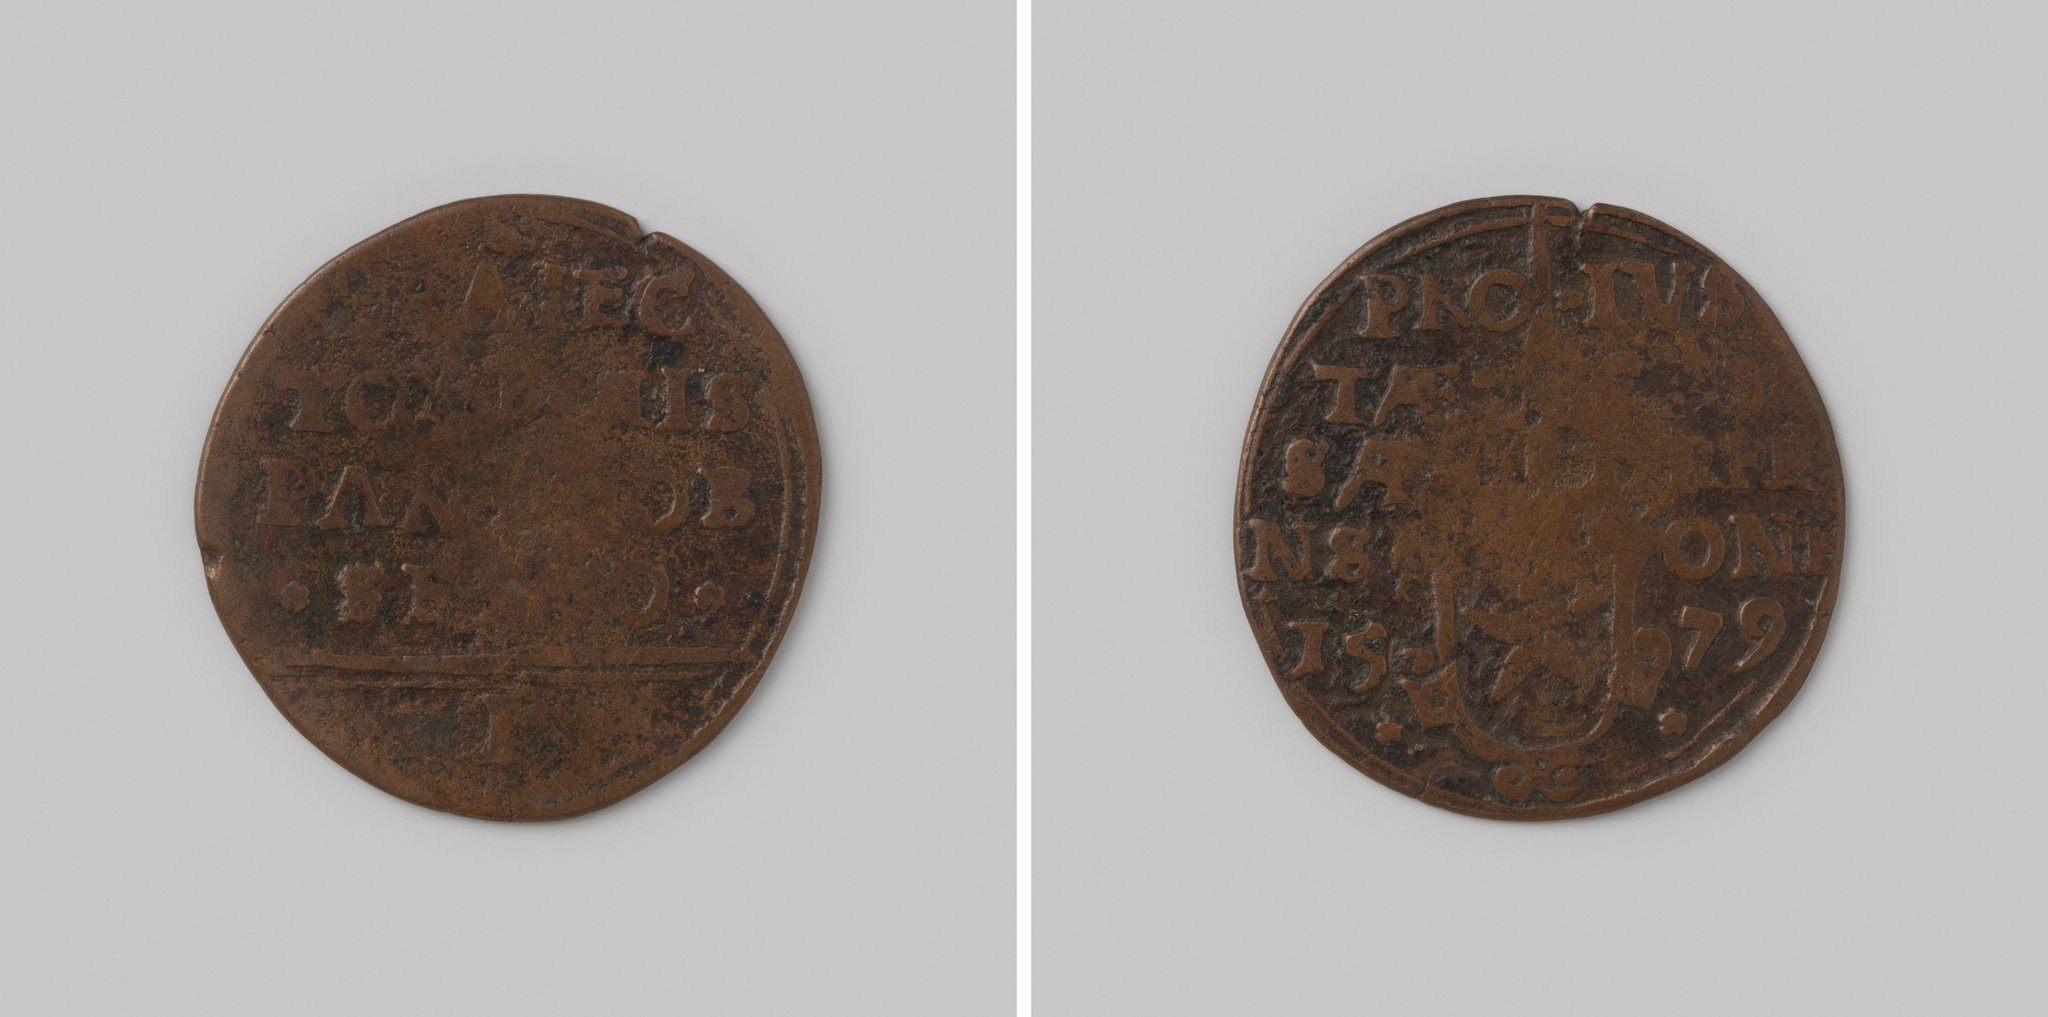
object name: siege coin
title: Stad Maastricht, noodmunt van 1 stuiver, 1579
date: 1579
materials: copper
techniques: striking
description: Koperen noodmunt. Voorzijde: Opschrift in vier regels: Traiecto ab Hispanis obsesso. In afsnede waarde-aanduiding. Keerzijde: zwaard boven stadswapen met aan weerszijden vijfregelig opschrift: pro ivstae cavsae defensione met jaartal.